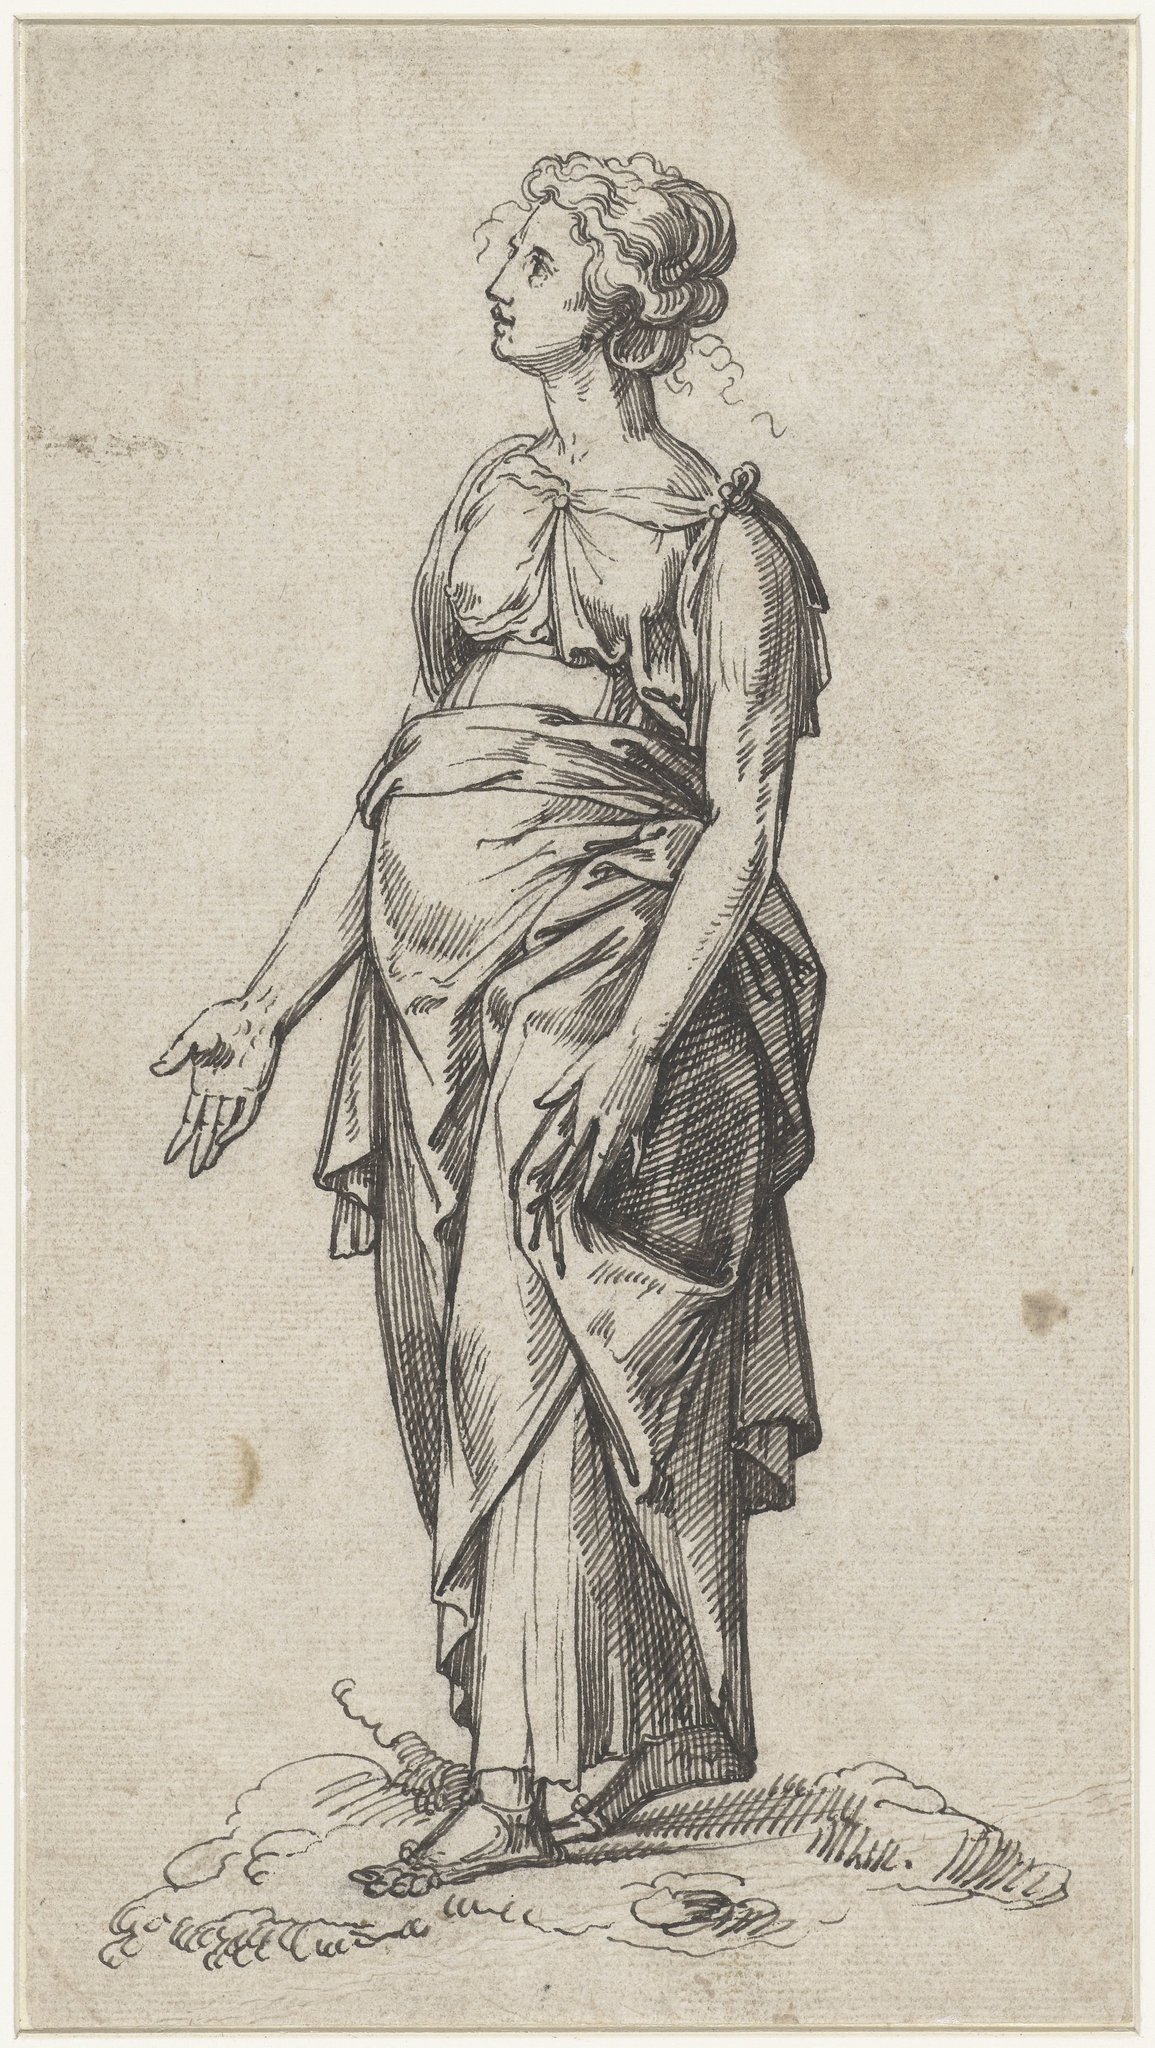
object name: drawing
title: Lopende vrouw, naar links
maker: Anonymous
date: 1500-1600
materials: ink, paper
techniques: pen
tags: standing figure - aa - female human figure